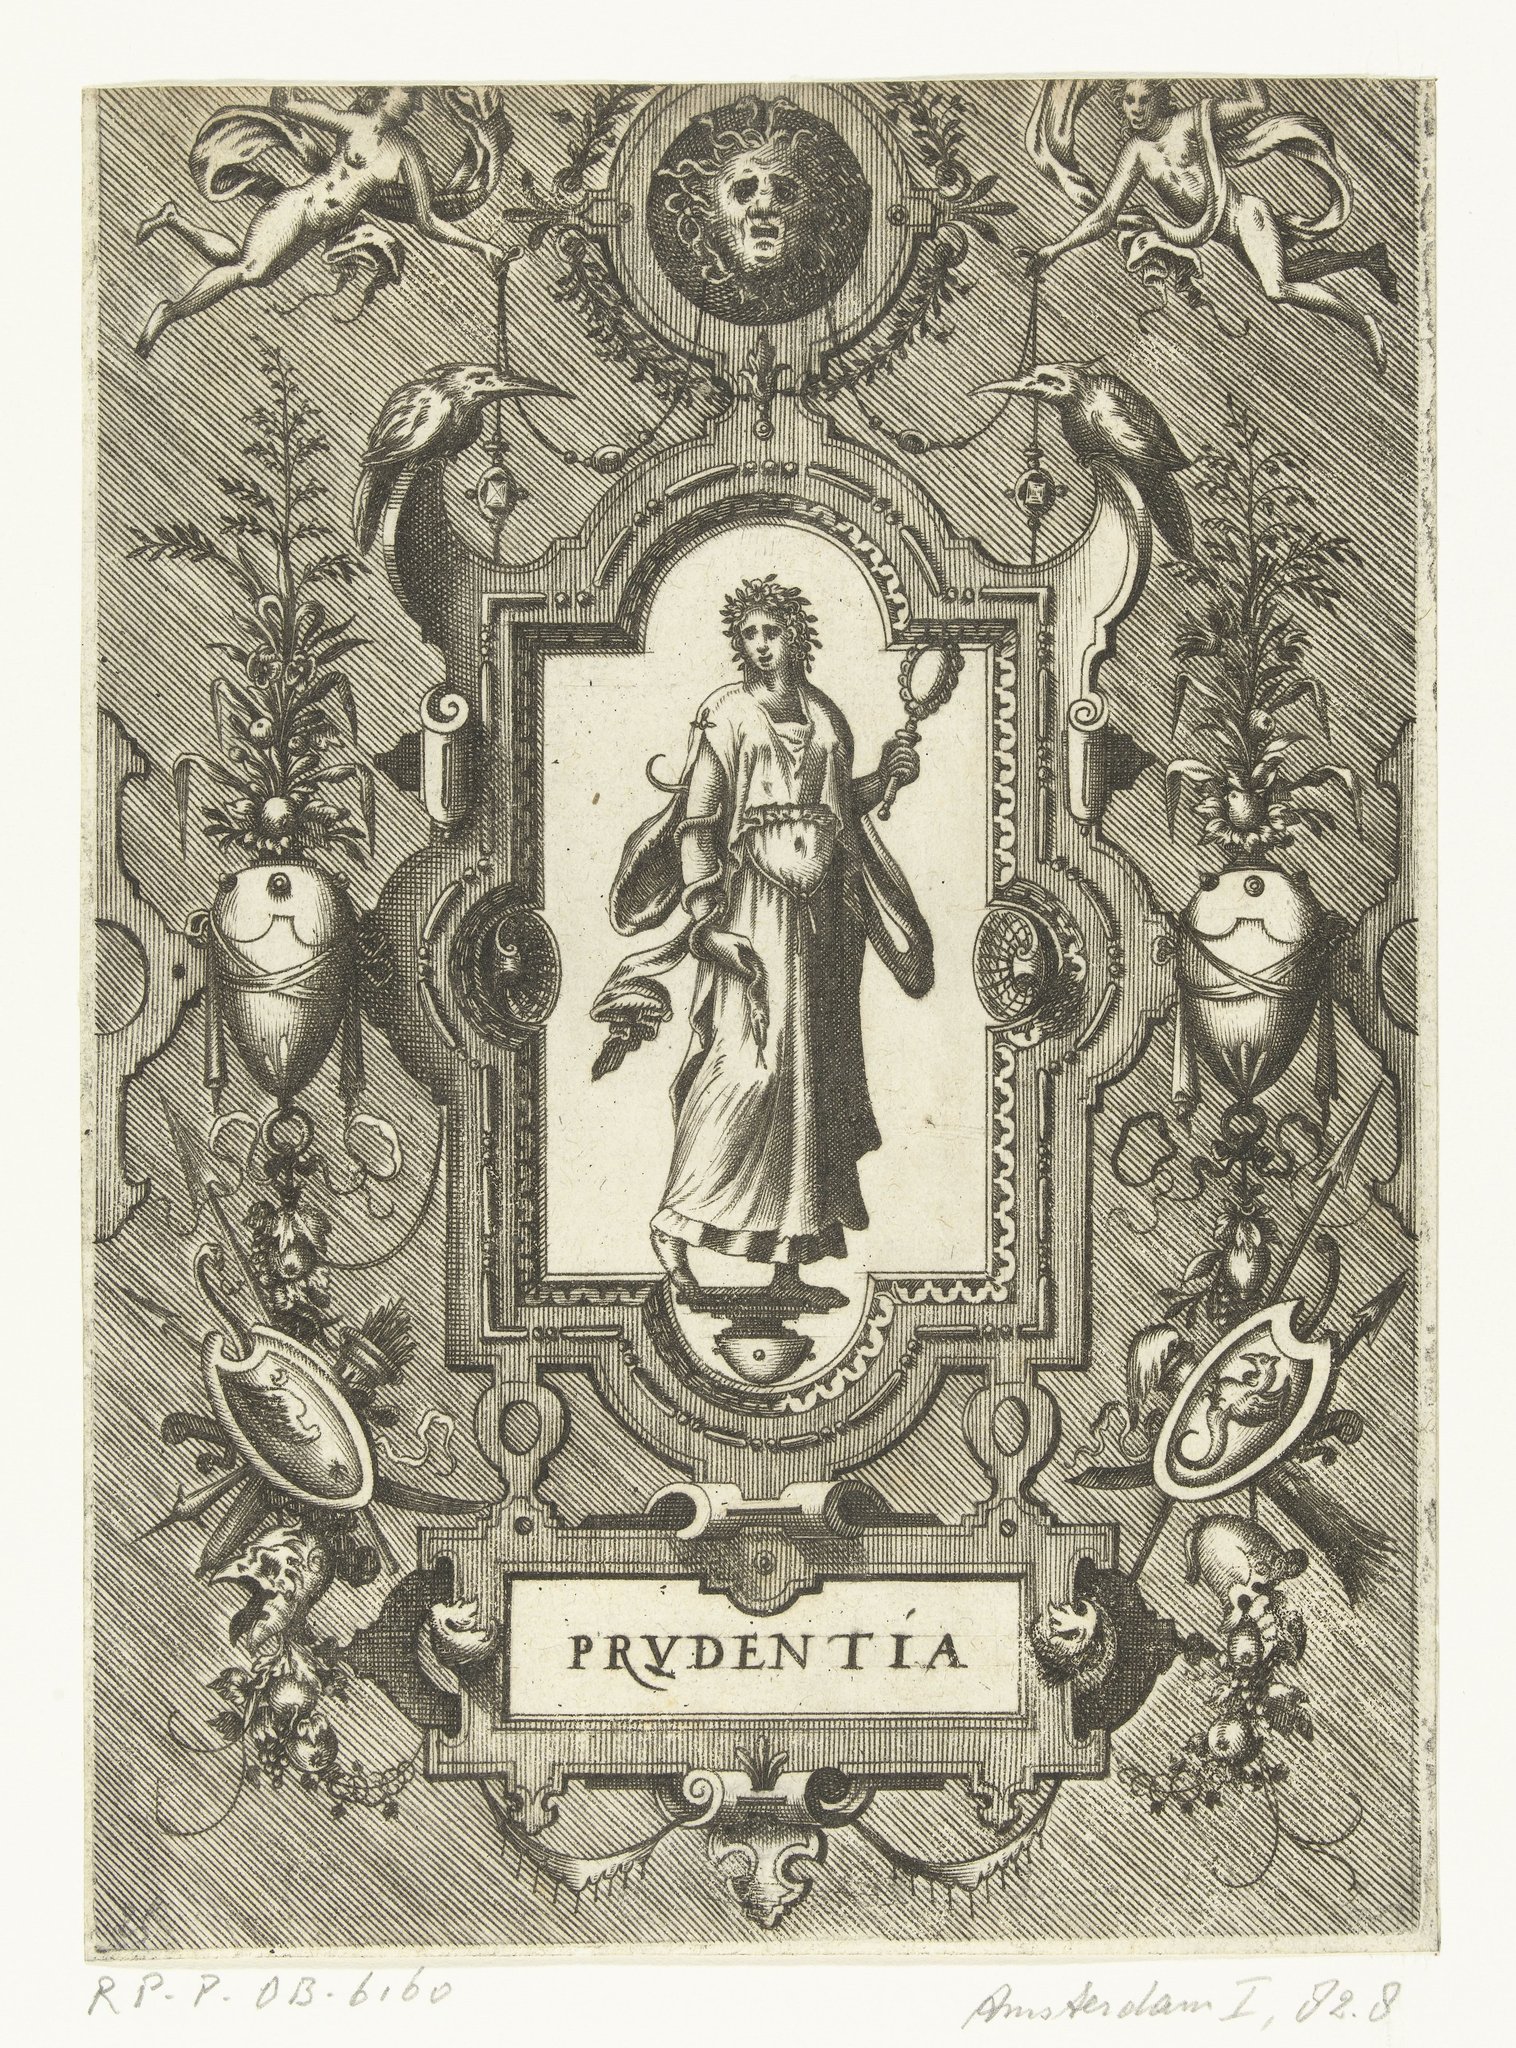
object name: print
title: Cartouche met Prudentia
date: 1567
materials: paper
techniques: engraving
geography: netherlands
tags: prudence, 'prudentia'; 'prudenza' (ripa) ~ one of the four cardinal virtues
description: Aan weerszijden van de cartouche is op het rolwerk een vaas met bloemen bevestigd. Aan beide vazen hangt een vruchtenguirlande met een wapentrofee. Gearceerde achtergrond. Hoort bij serie van 14 bladen cartouches met rolwerk, grotesken, trofeeën en friezen. Het titelblad ontbreekt.